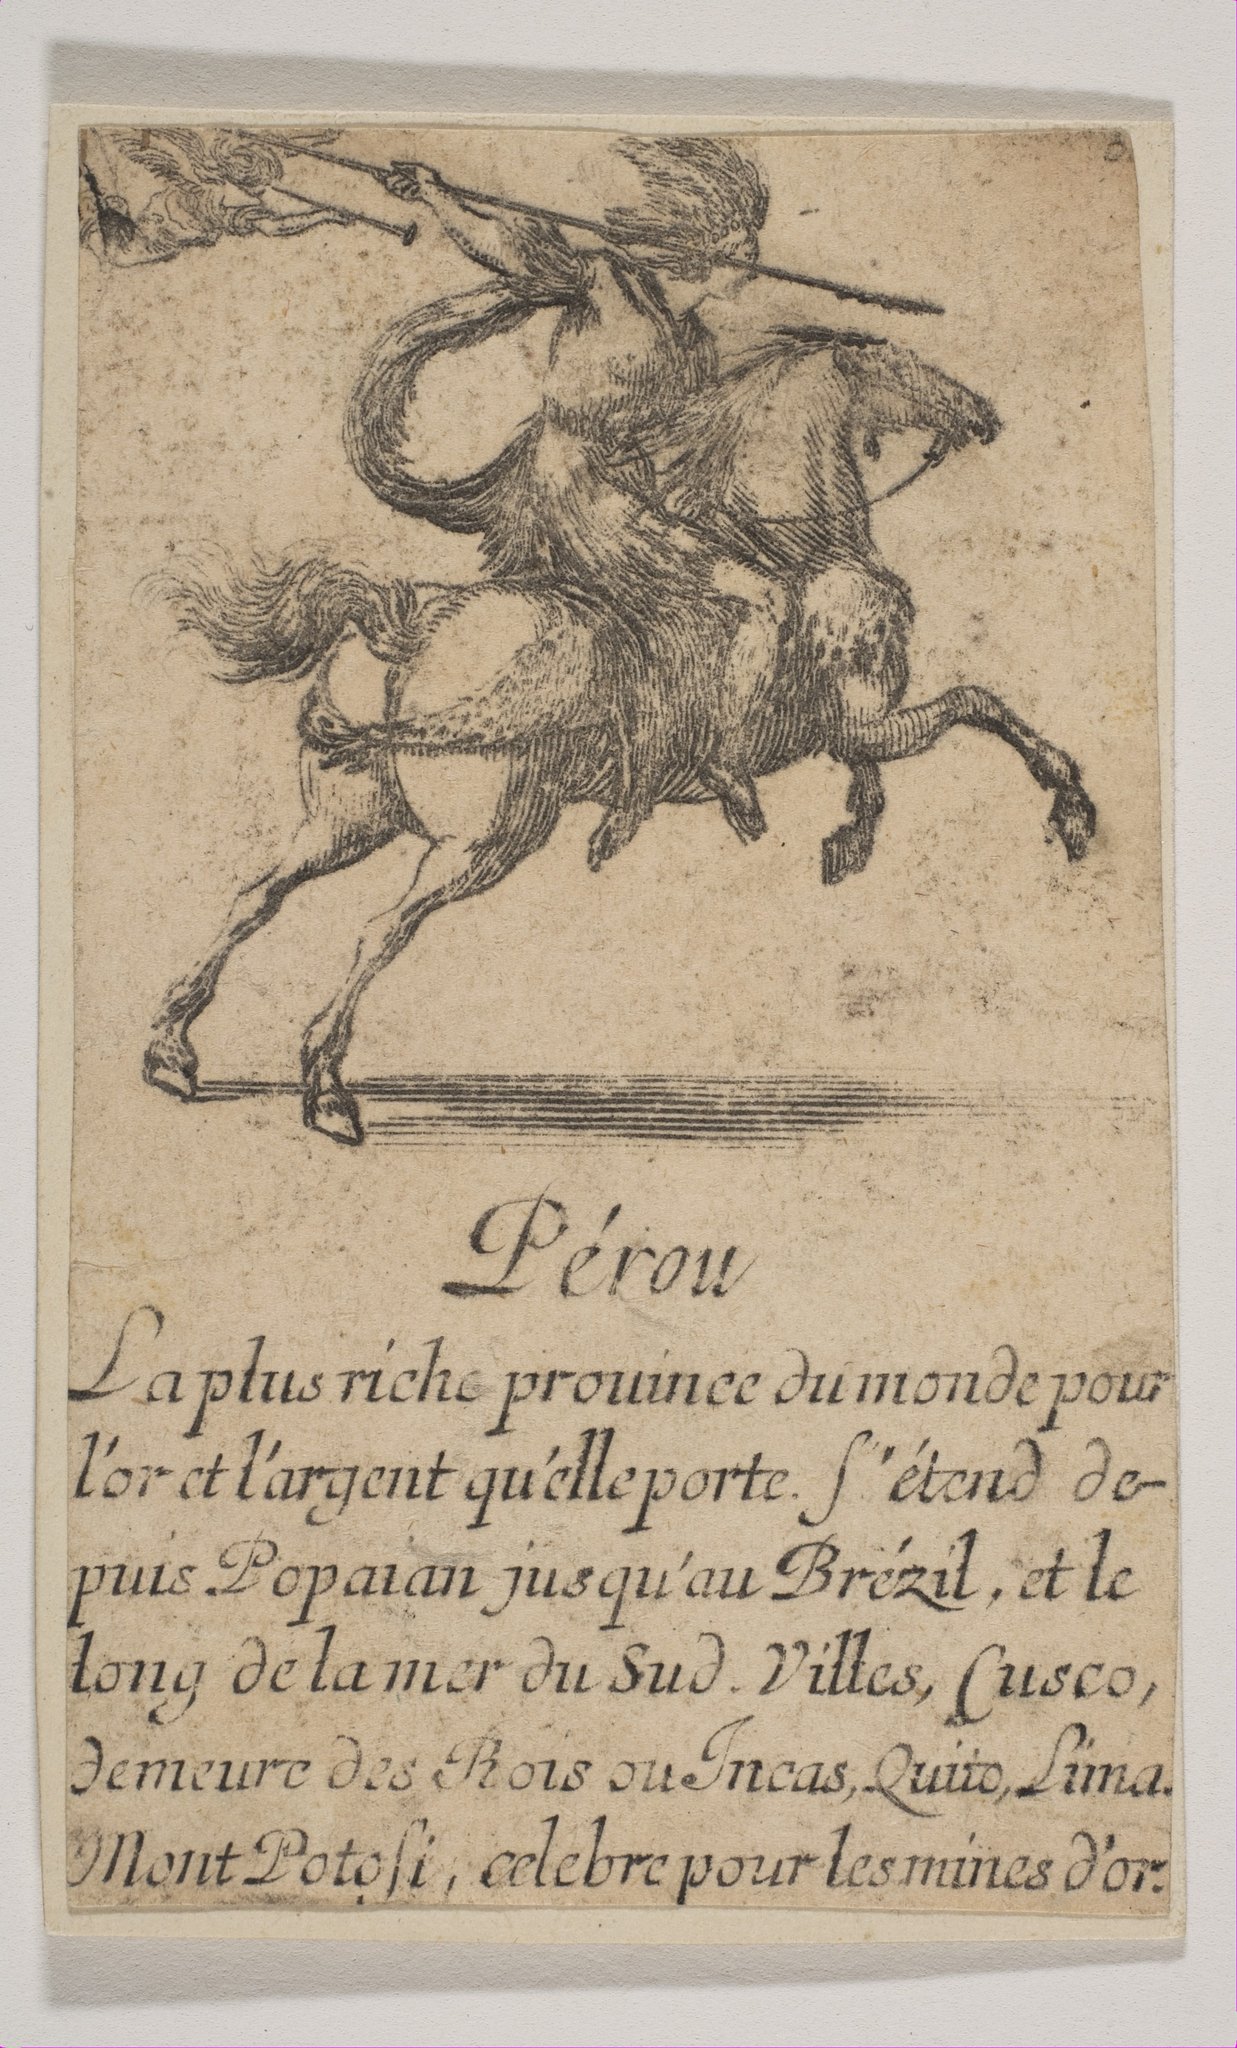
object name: print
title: Pérou, from the playing cards "Jeu de la Géographie"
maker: stefano della bella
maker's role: artist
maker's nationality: italian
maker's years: 1610-1664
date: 1644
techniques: etching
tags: human figures,spears,horses